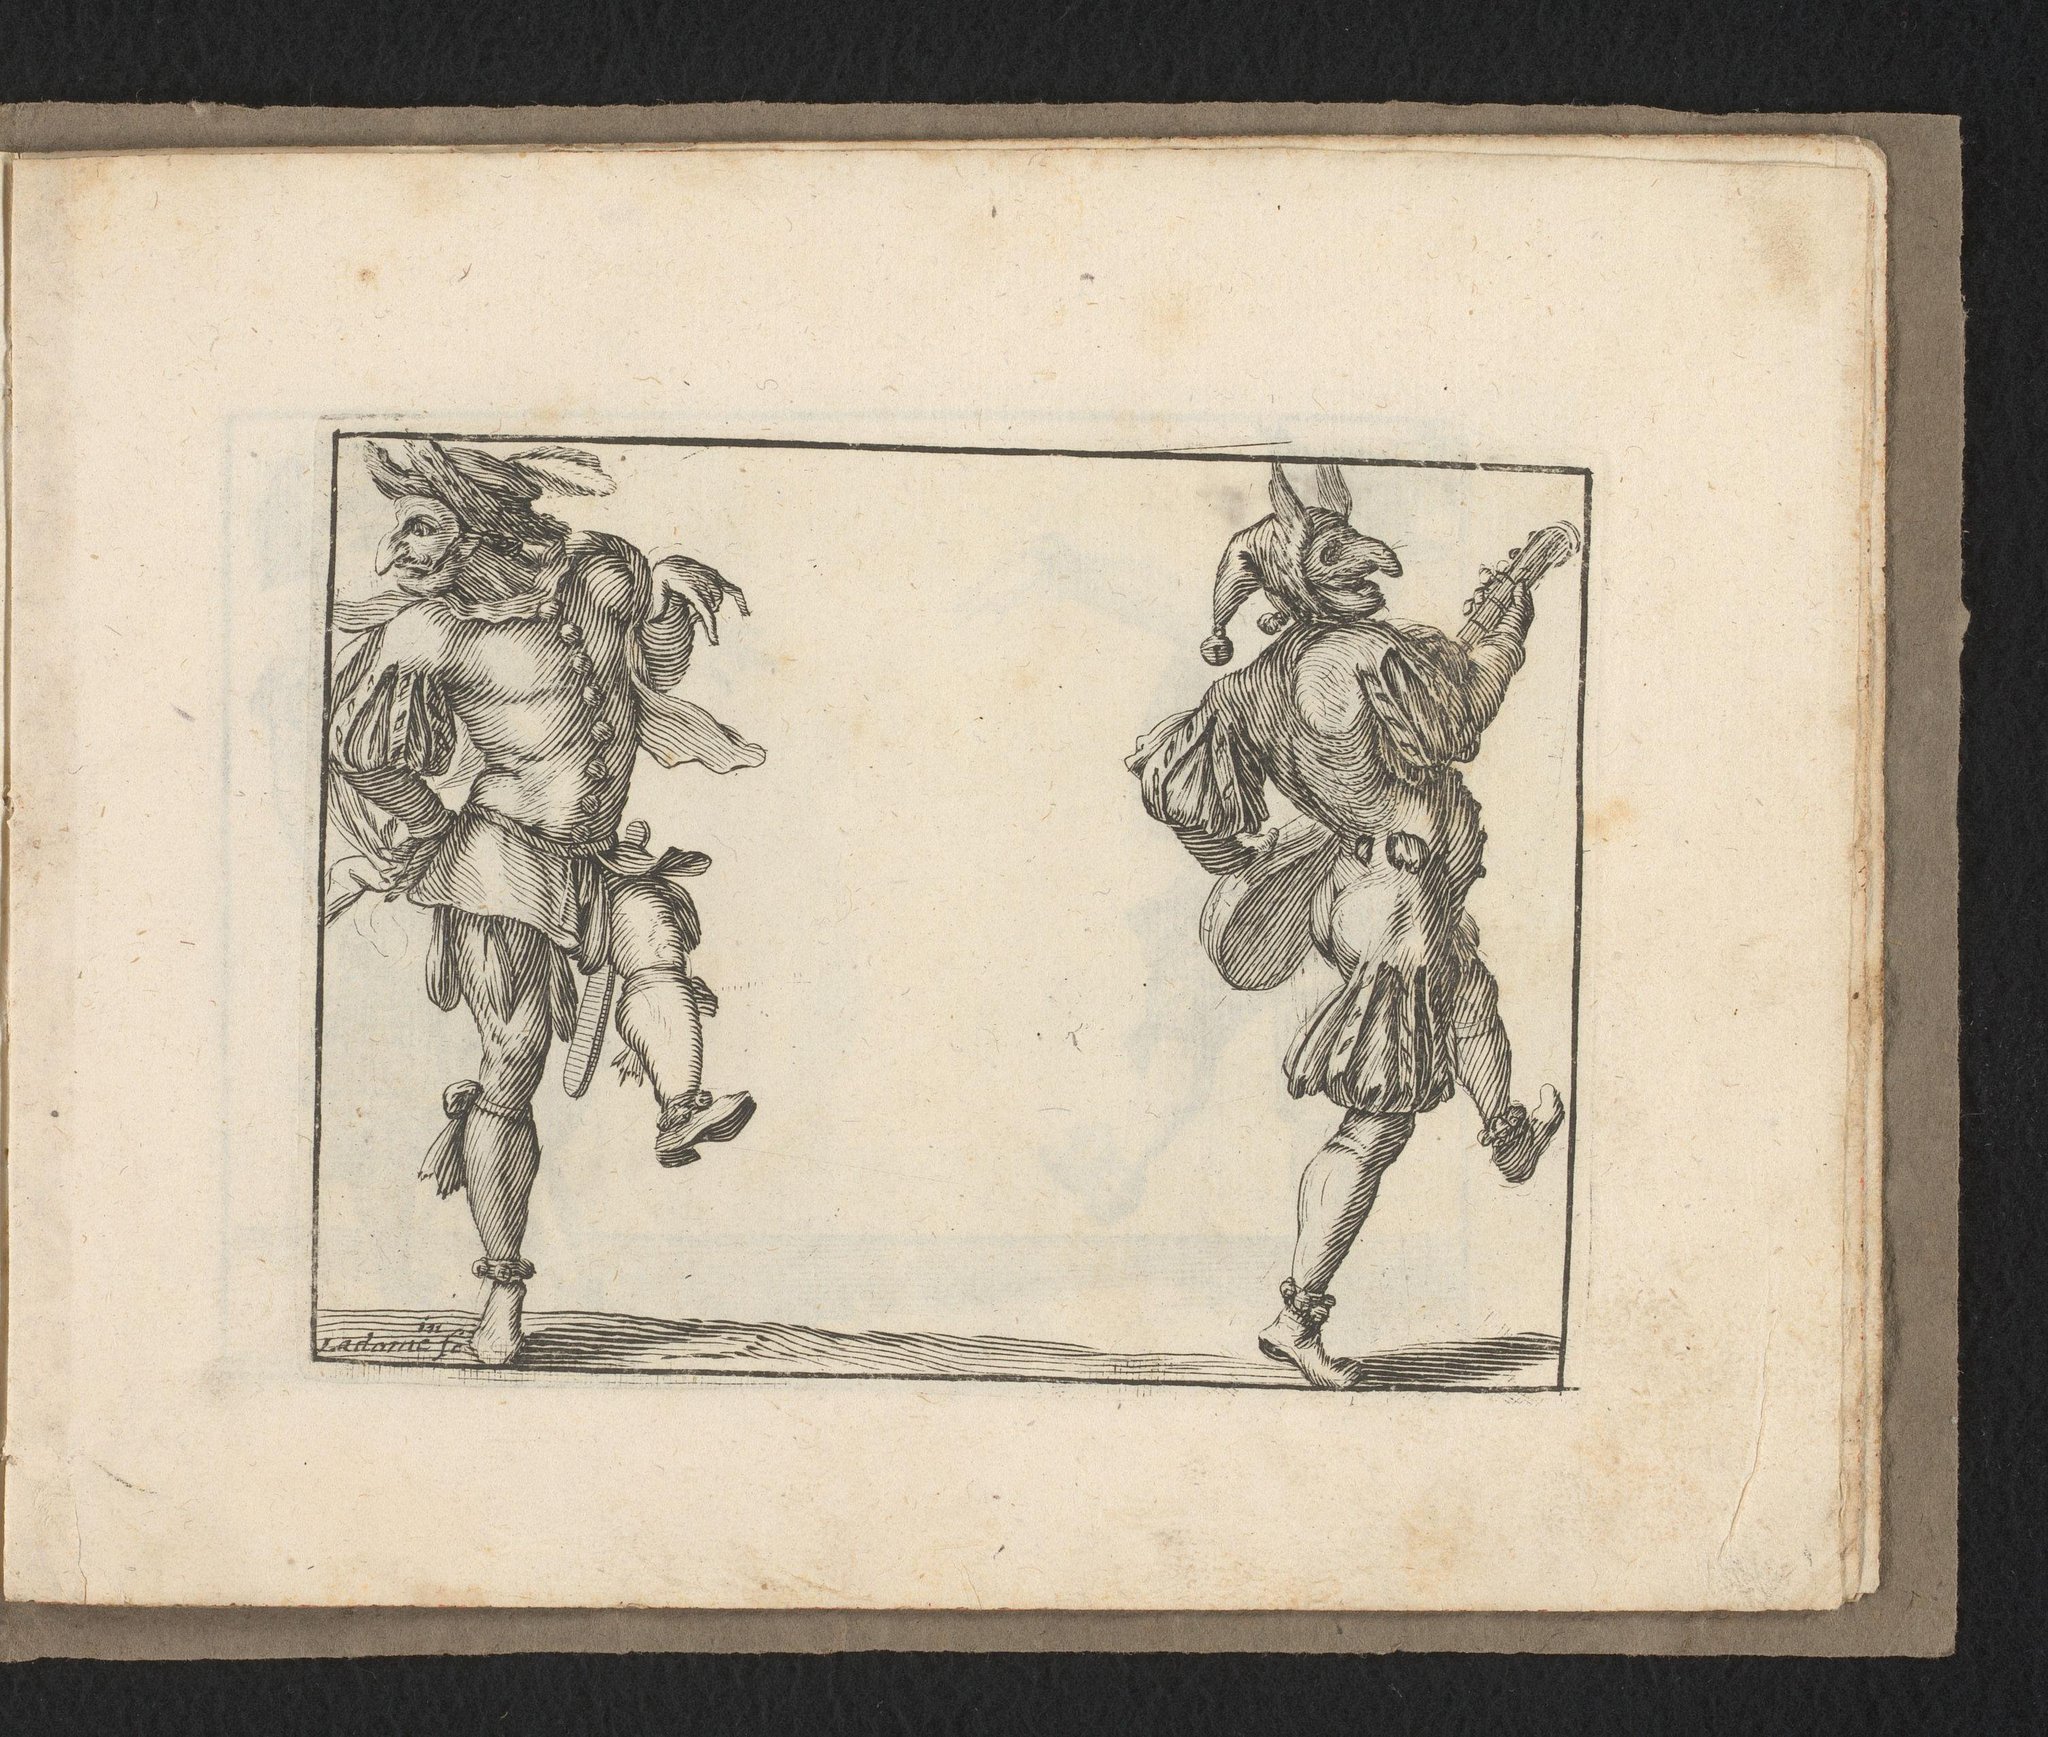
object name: album leaf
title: Verschillende figuren om kinderen te leren tekenen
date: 1660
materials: paper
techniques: etching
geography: paris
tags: types in 'commedia dell'arte', lute, and special forms of lute, e.g.: theorbo - cc - out of doors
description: De ene man met cistern, de andere dansend. Deze prent maakt deel uit van een album.